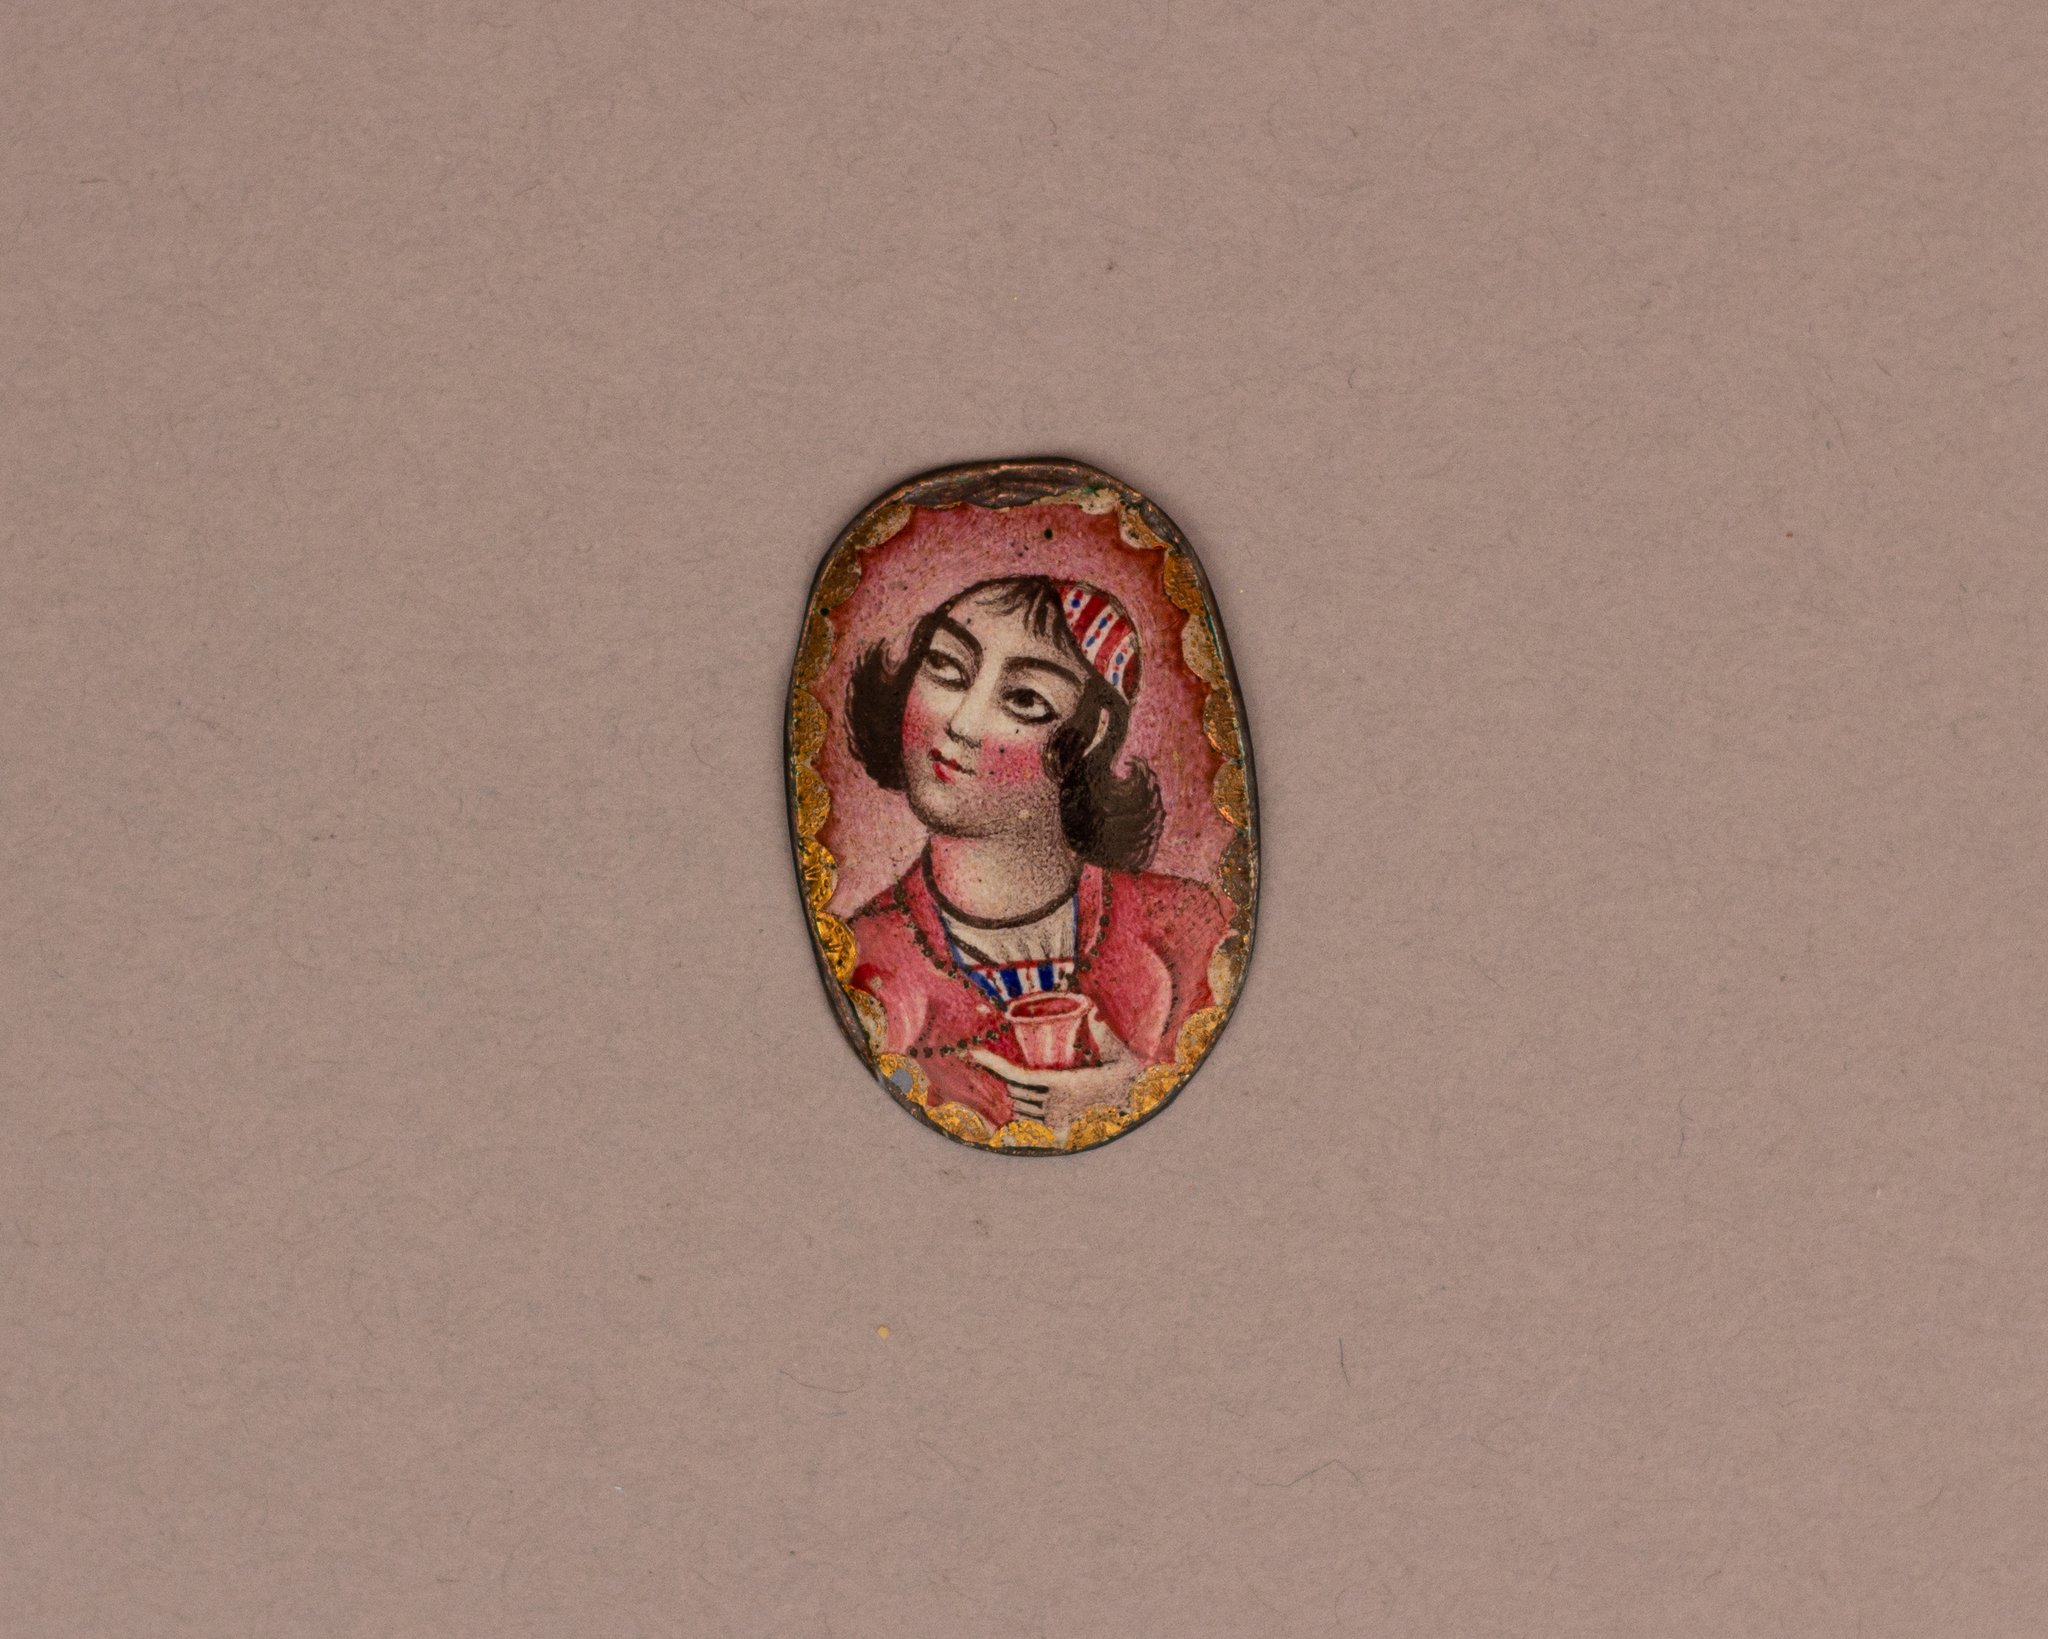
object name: disk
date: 1767-1800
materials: enamel, gold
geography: iran